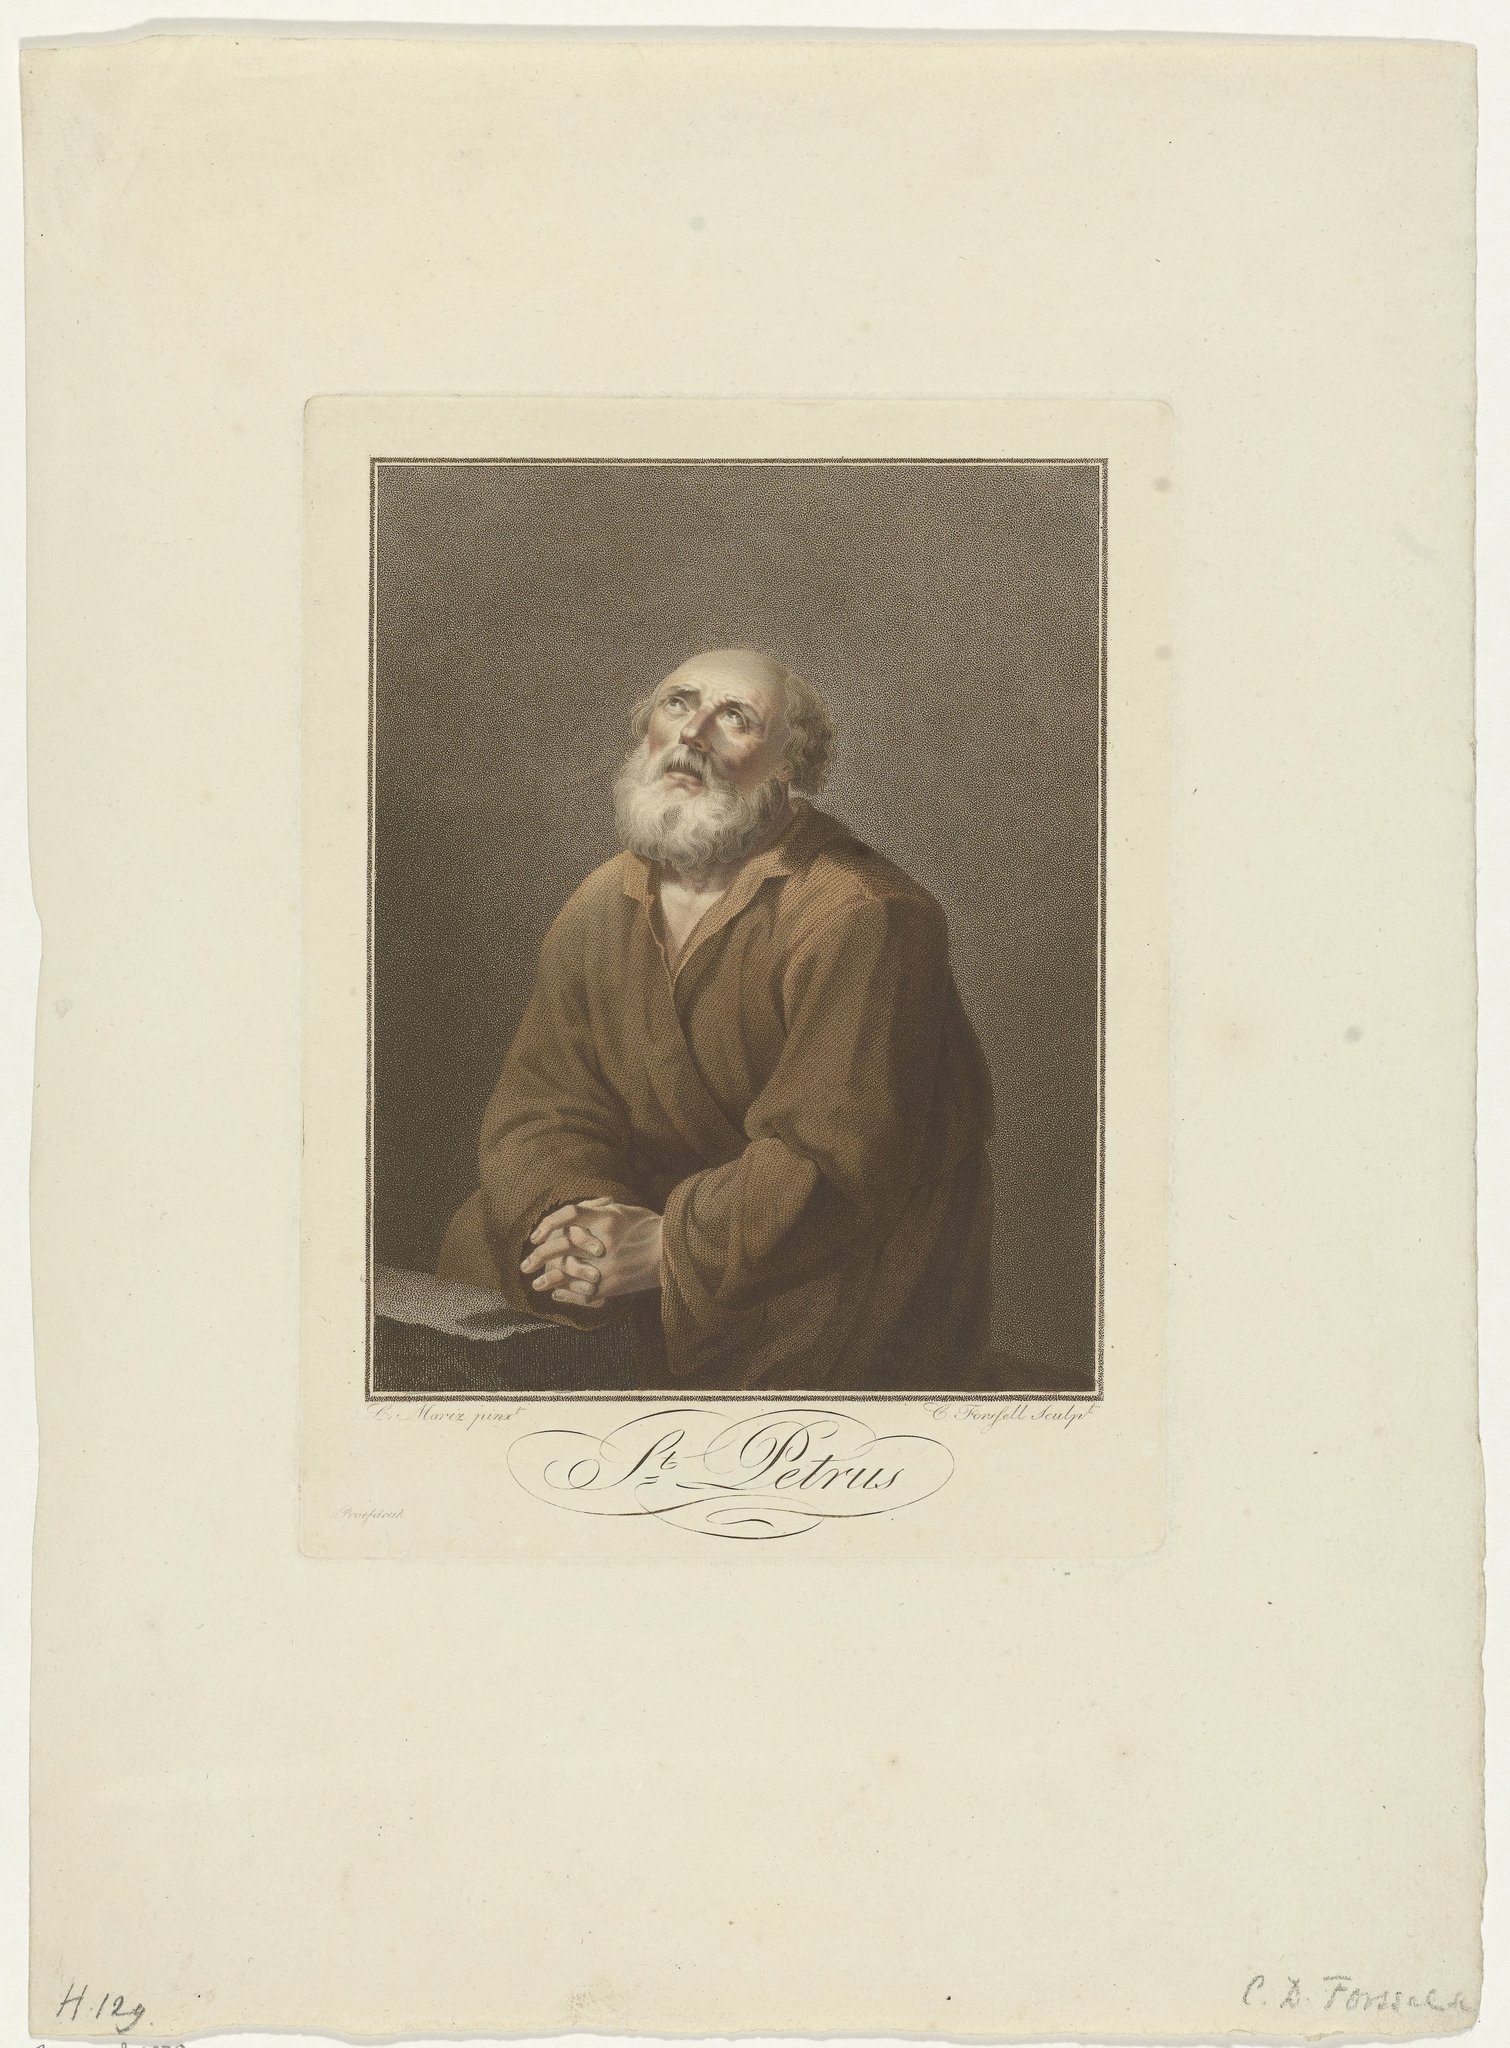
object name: print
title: St Petrus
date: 1787-1852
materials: paper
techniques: engraving, hand coloring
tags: one person praying, the apostle peter, first bishop of rome; possible attributes: book, cock, (upturned) cross, (triple) crozier, fish, key, scroll, ship, tiara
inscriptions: collector's mark: Lugt 2228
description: Apostel Petrus in gebed, ten halven lijve. Met de handen ineengevouwen kijkt hij omhoog.